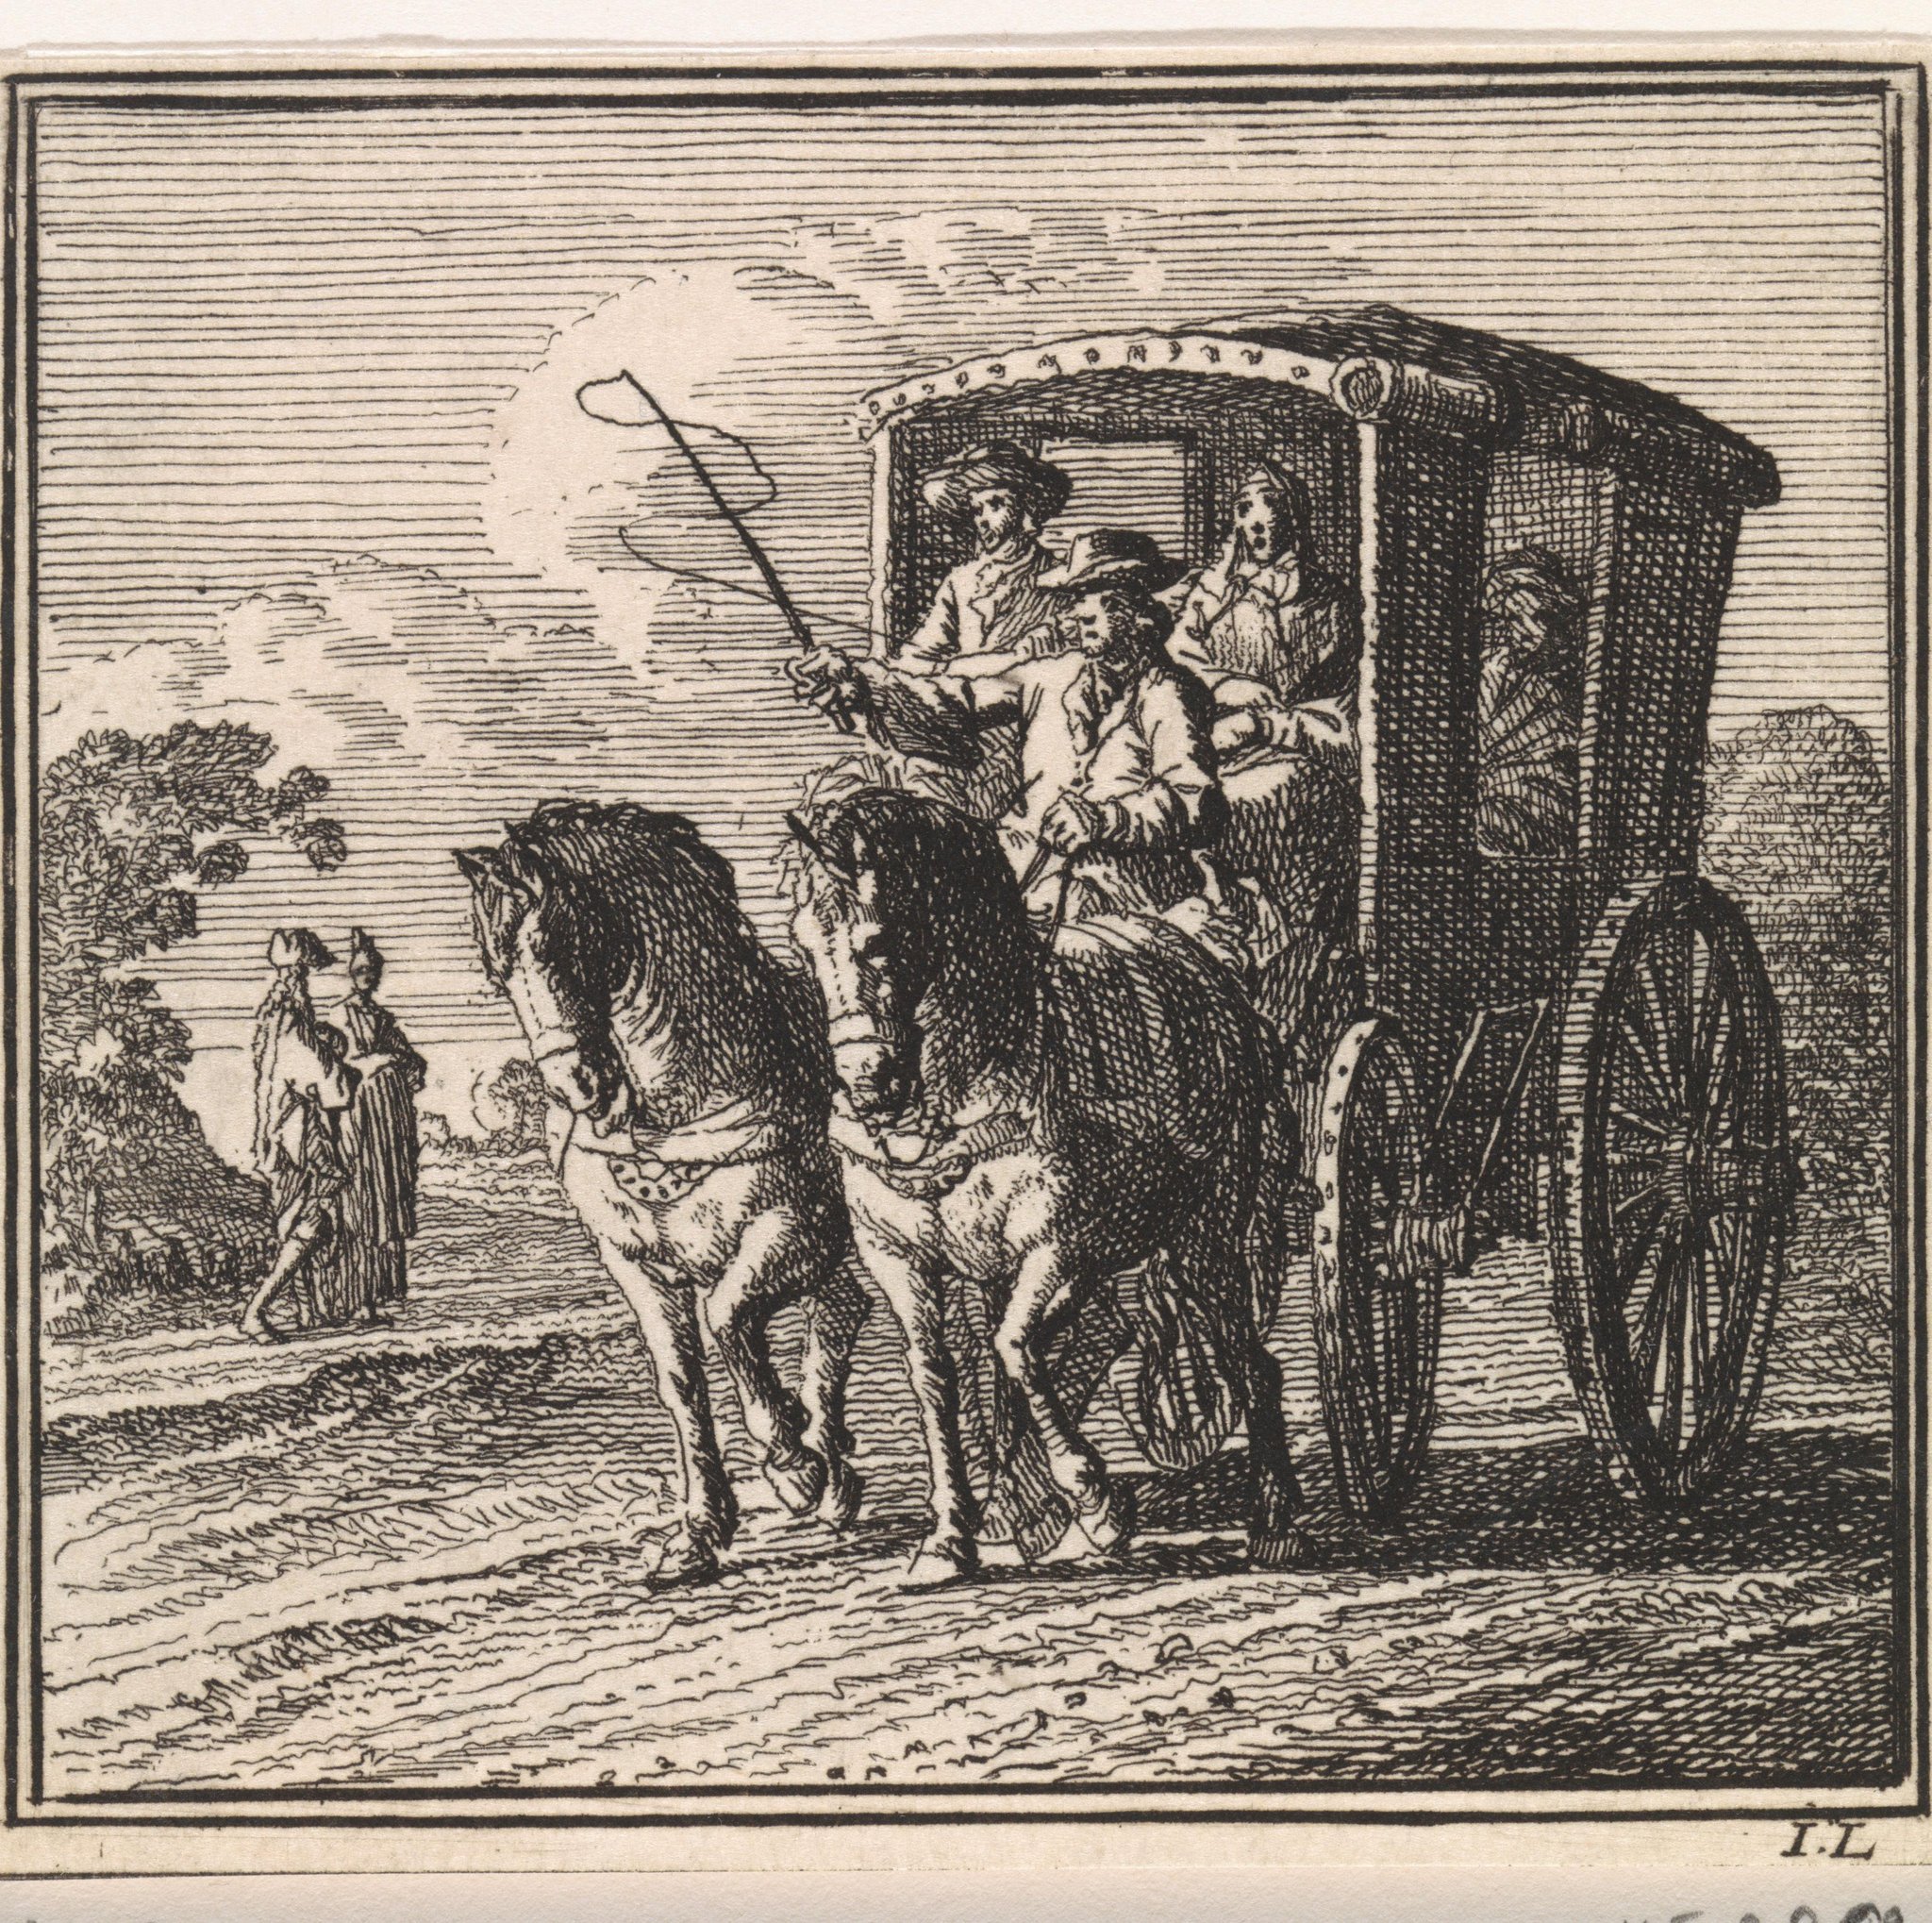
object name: book illustration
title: Vier figuren in een koets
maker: jan luyken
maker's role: draughtsman, print maker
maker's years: 1649-1712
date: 1711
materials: paper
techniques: etching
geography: amsterdam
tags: four-wheeled vehicle drawn by two animals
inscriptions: collector's mark: Lugt 2228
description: Illustratie voor: Luyken, Jan. De Bykorf des Gemoeds. Amsterdam: Pieter Arentsz. II (wed.) en Cornelis van der Sys, 1711, p. 82.